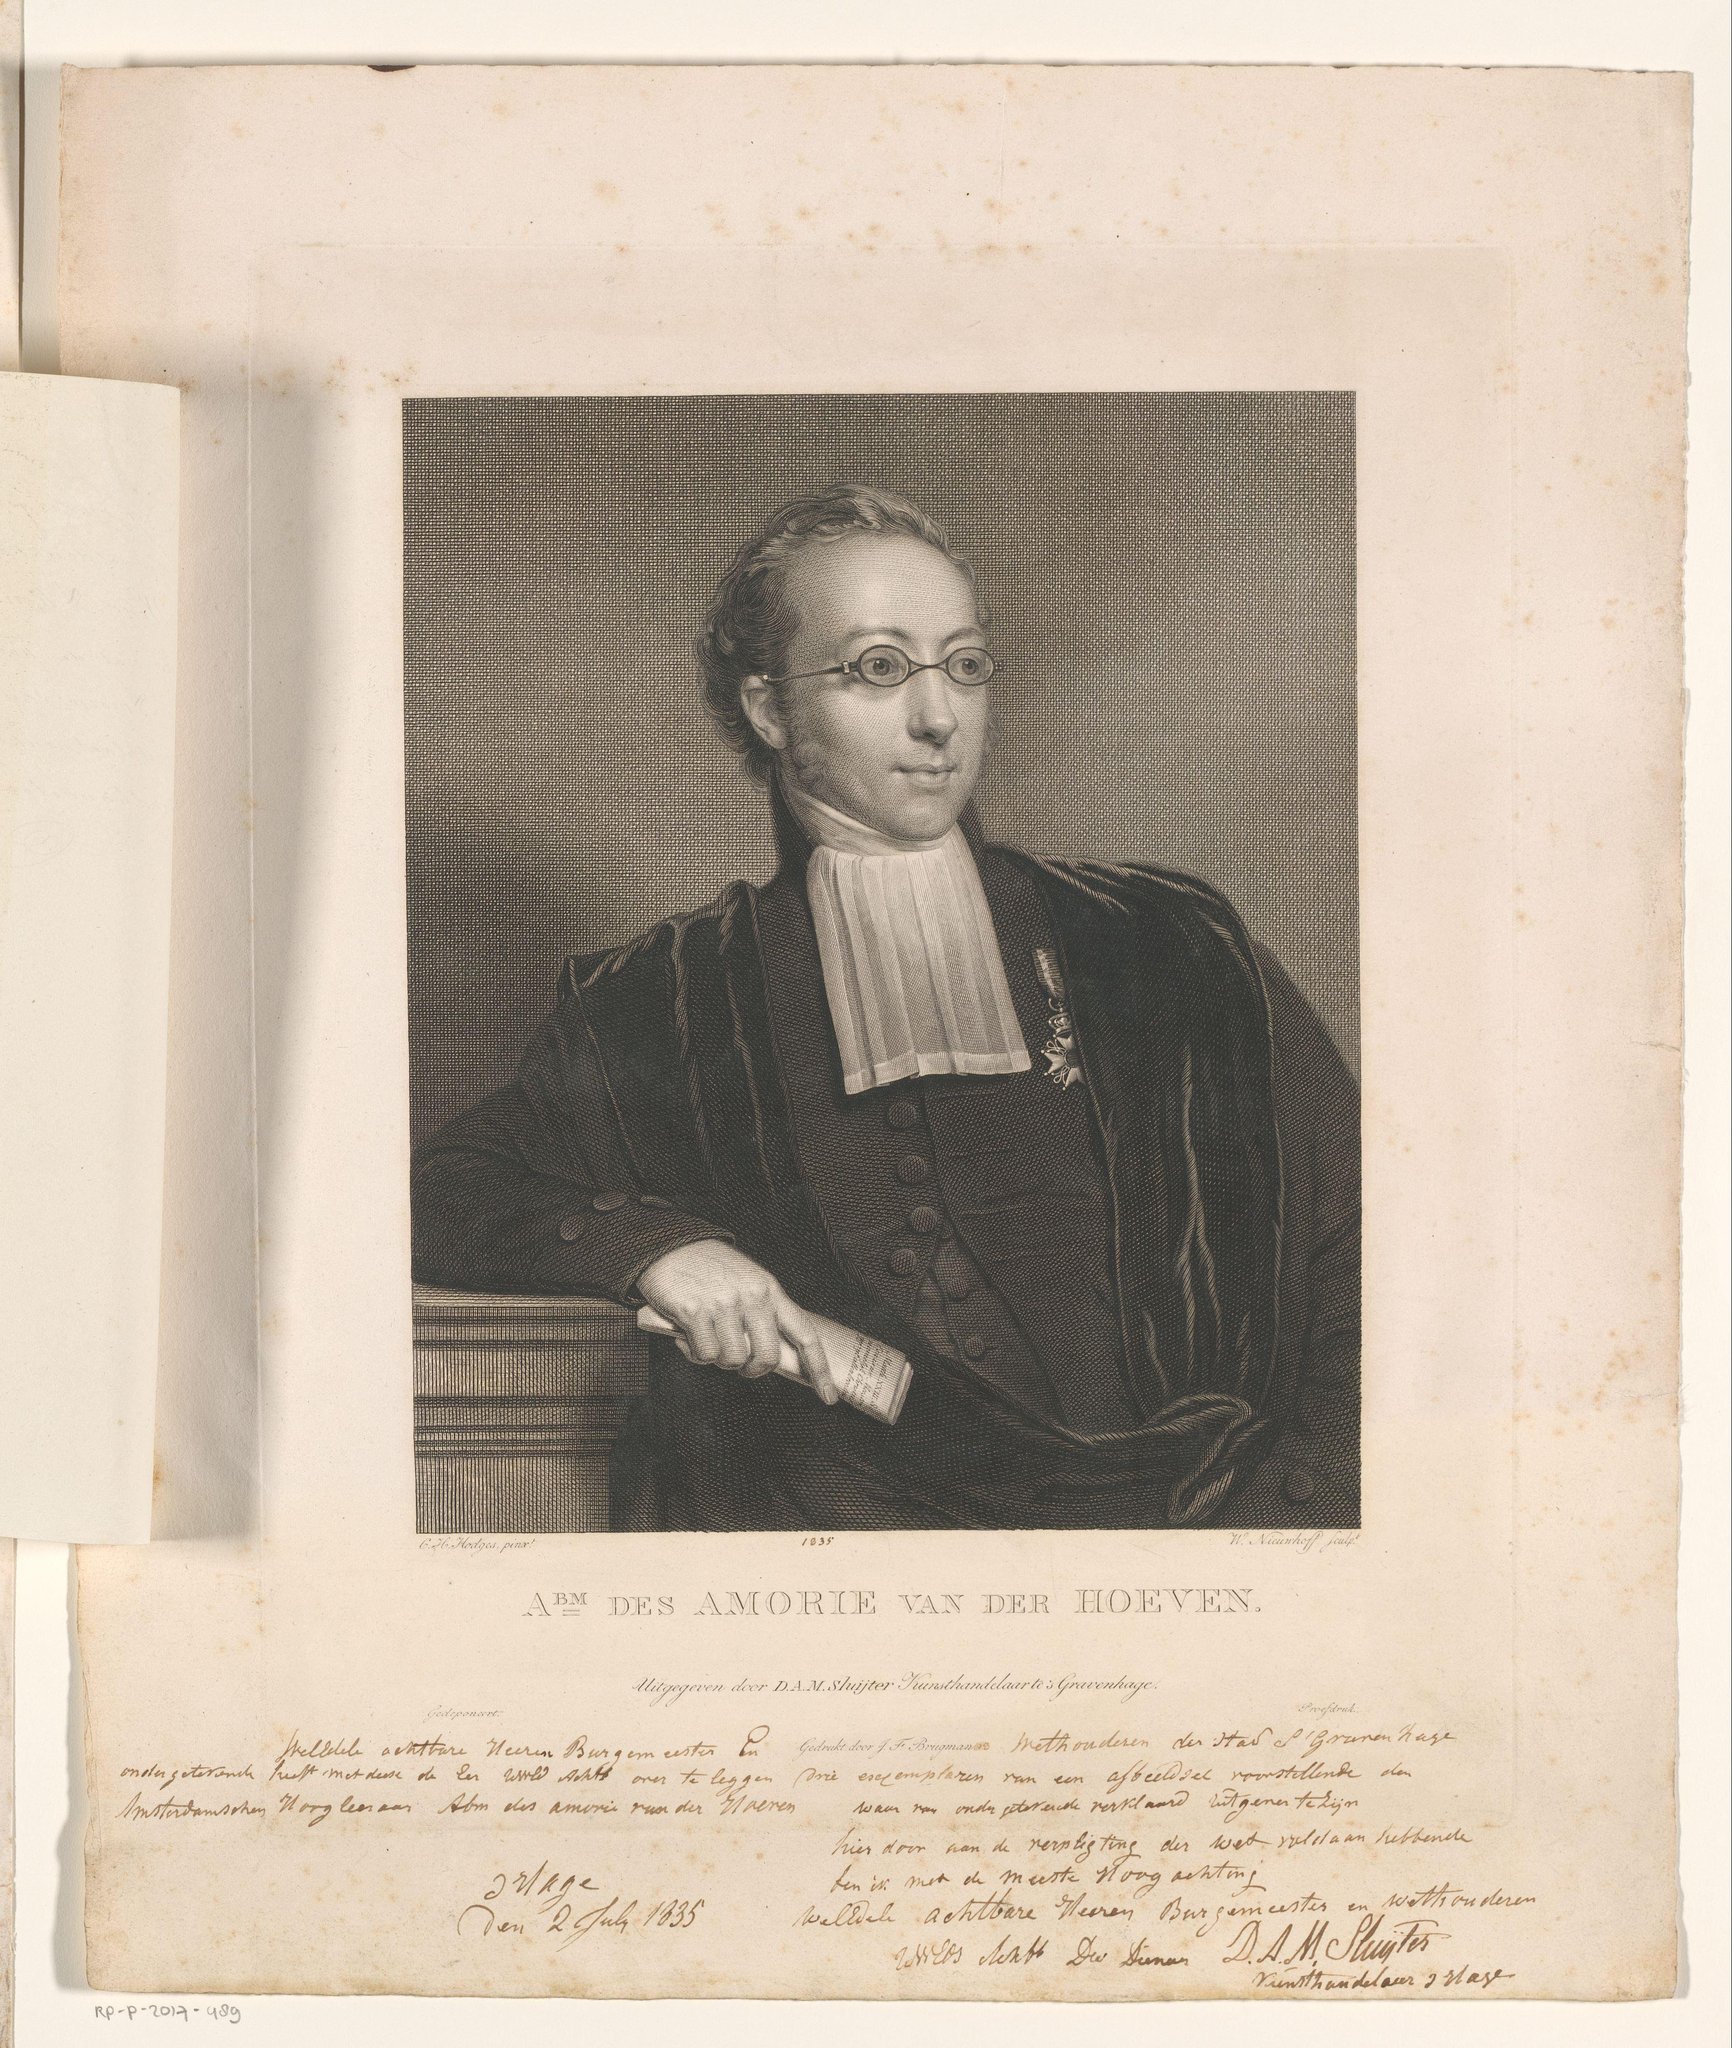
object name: print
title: Portret van Abraham des Amorie van der Hoeven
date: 1835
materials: paper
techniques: engraving, etching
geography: amsterdam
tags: arnhem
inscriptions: : ‘Weledele achtbare heeren Burgemeester en wethouderen der stad 's Gravenhage / ondergeteekende heeft met deze de eer (...) acht over te leggen drie exemplaren van een afgebeeldsel voorstellende den / Amsterdamschen Hoogleeraar Abm des Amorie van der Hoeven waar van ondergeteekende verklaard uitgever te zijn / hier door aan de verpligting der wet voldaan hebbende / ten iv met de meeste hoogachting / weledele achtbare heeren burgemeeester en wethouderen / (...) D.A.M.Sluijters / kunsthandelaar s' Hage / s Hage / den 2 july 1835’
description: Aan de prent is een stuk papier bevestigd met de volgende tekst: "De Ondergetekende Jan Frederik Brugman kunstplaatdrukker te Amsterdam onder de firma van de Wed. A. Koning & J.F. Brugman verklaart bij deze dat de portraiten van den hoogleraar Abm. des Amorie van der Hoeven door hem zelve aan zijne kunstplaatdrukkerij voor den heer D:A:M:Sluyter kunsthandelaar te 's Hage zijn gedrukt en afgewerkt. Amsterdam 25 juny 1800 vijf en dertig J.F.Brugman."